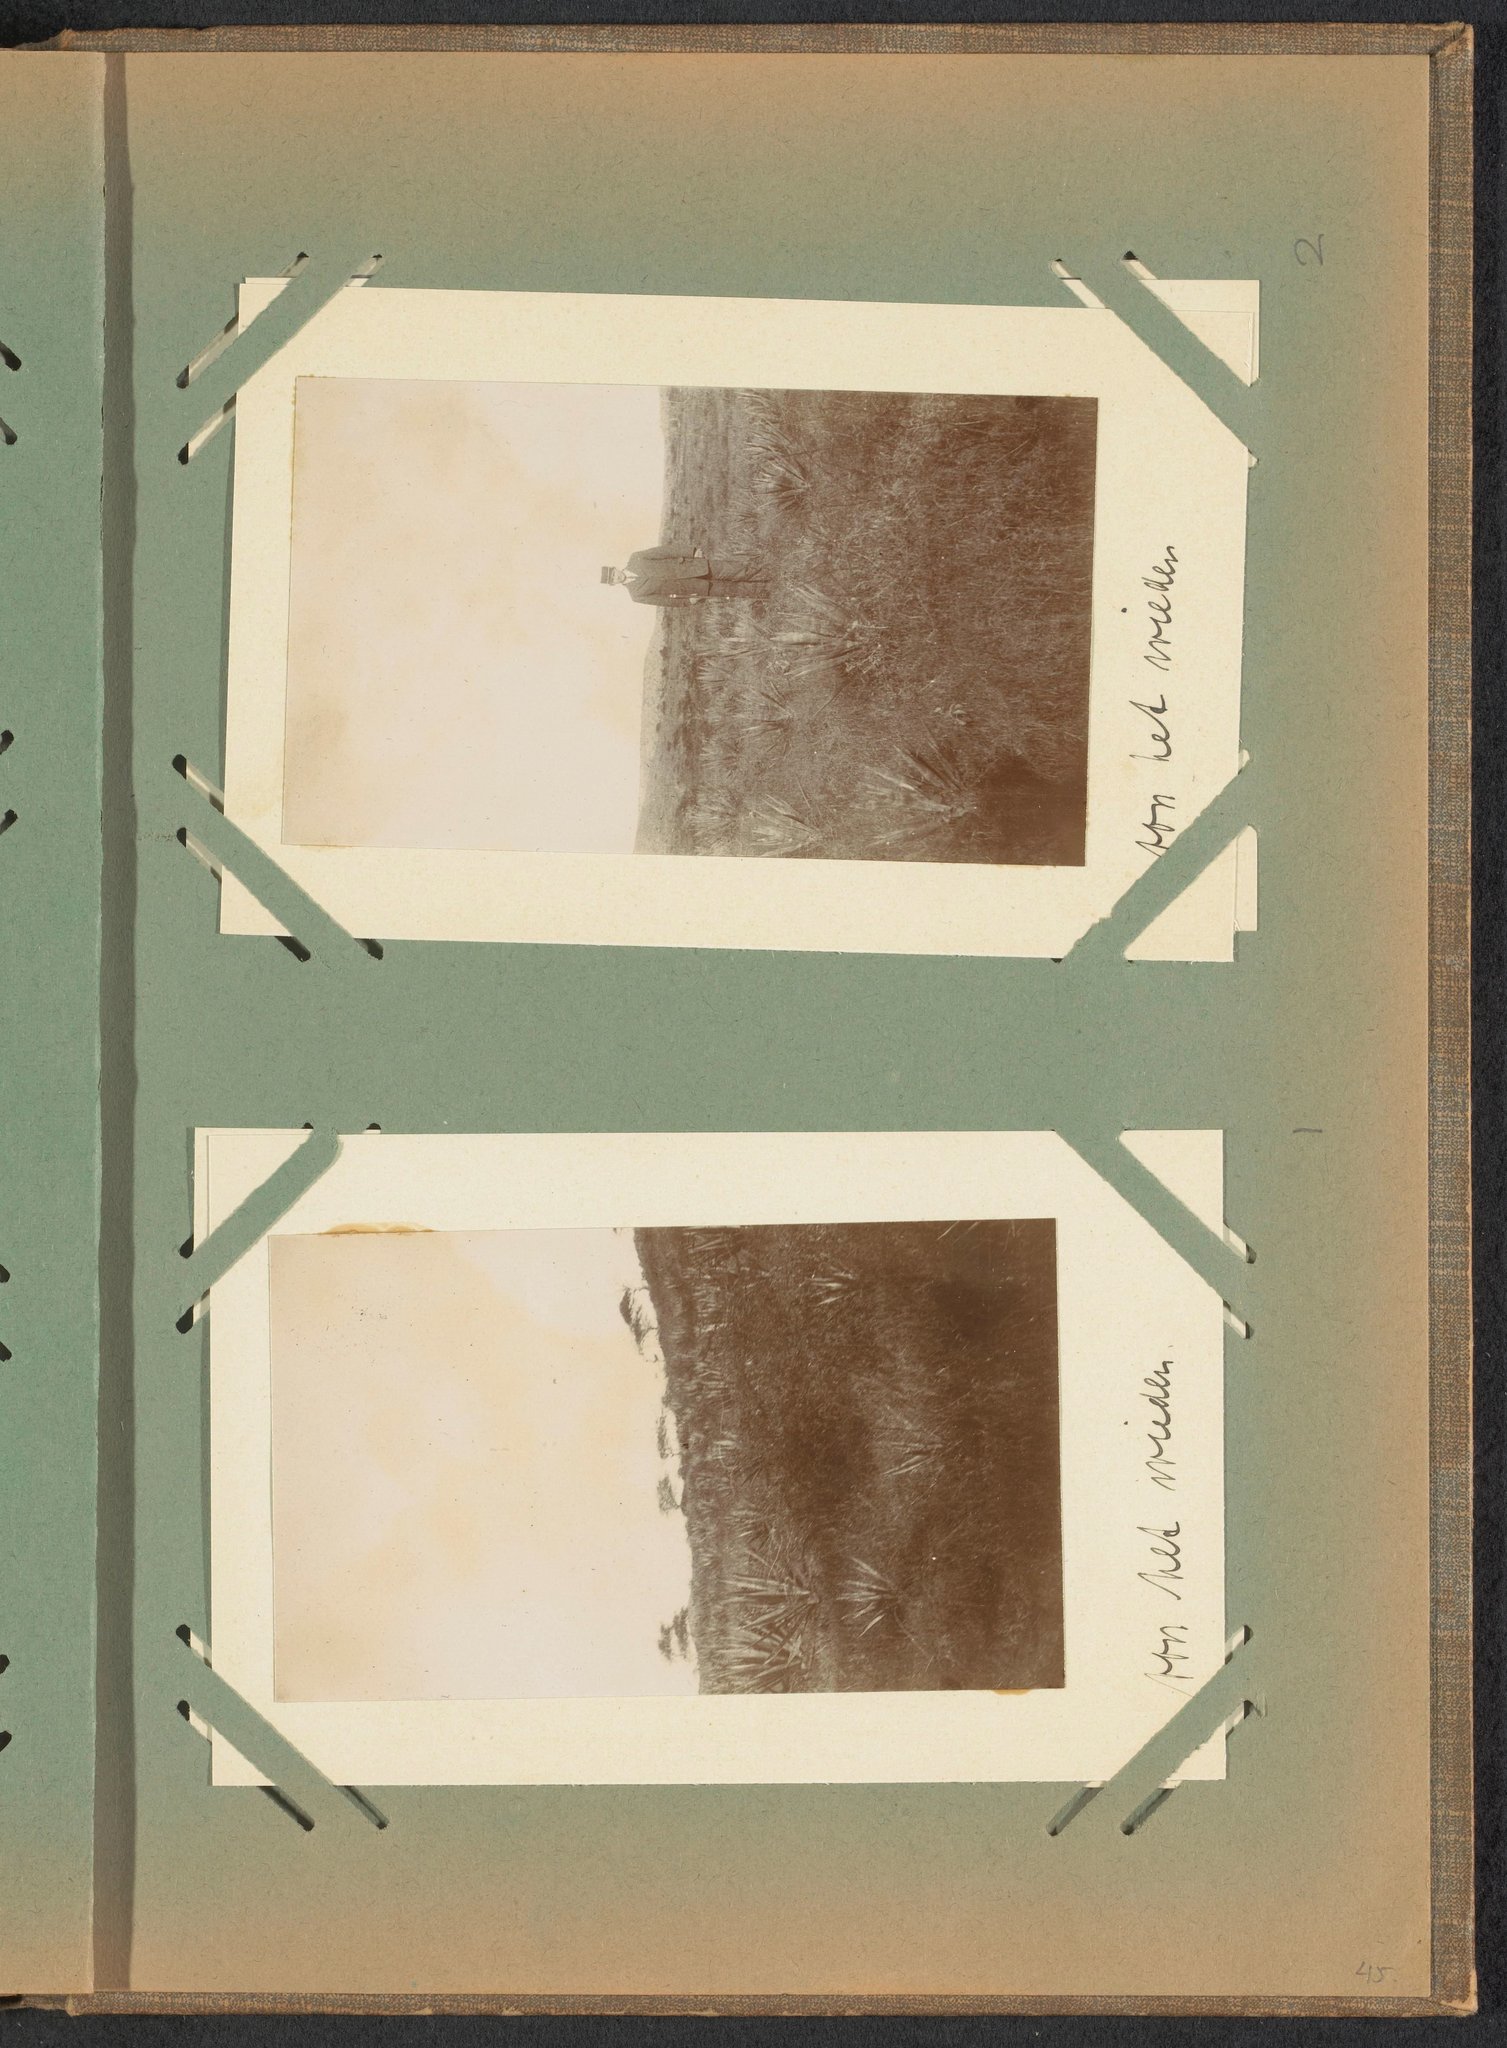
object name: photograph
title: Ongewied veld met sisalplanten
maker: Anonymous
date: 1912-1913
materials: paper, photographic support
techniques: gelatin silver print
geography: curacao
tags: plantation, (non-fruit) products of plants or trees: sisal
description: Ongewied veld met sisalplanten (in of vóór 1913) op Plantage Mount Pleasant op Curaçao. Onderdeel van het fotoalbum uit ca. 1912-1913 met 92 foto's van de plantages Peperpot en Dordrecht in Suriname en Mount Pleasant op Curaçao.